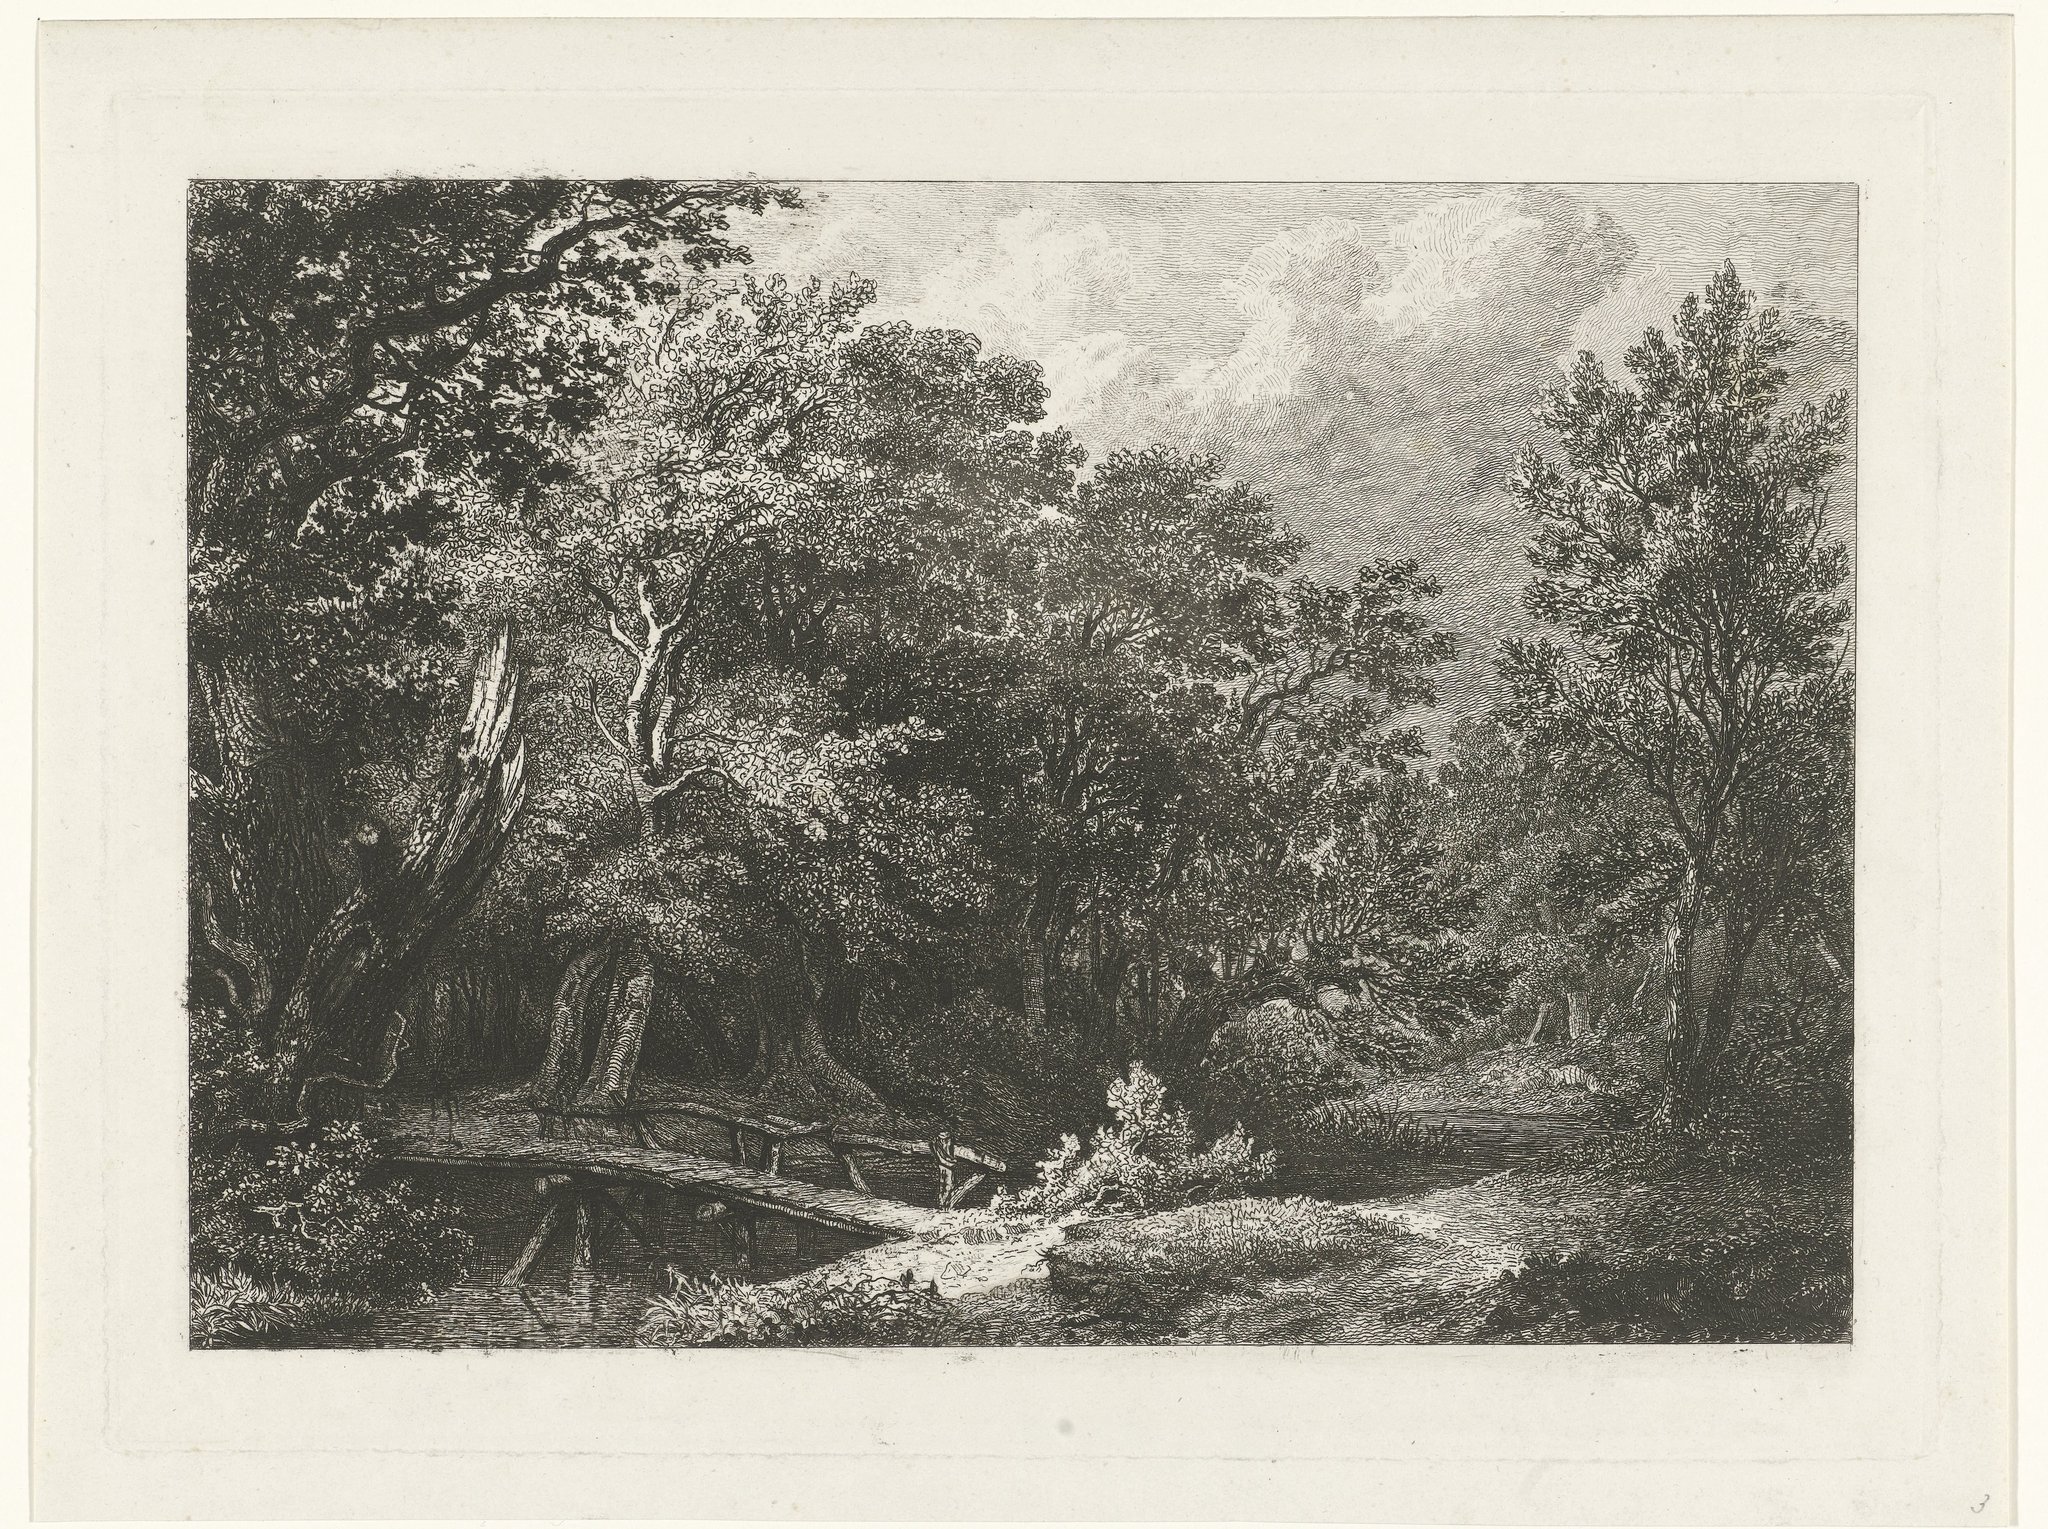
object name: print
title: Bosgezicht met houten brug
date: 1820-1886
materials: paper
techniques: etching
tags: water course, forest, wood, bridge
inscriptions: collector's mark: Lugt 2228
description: Bos met links een houten brug over het water.